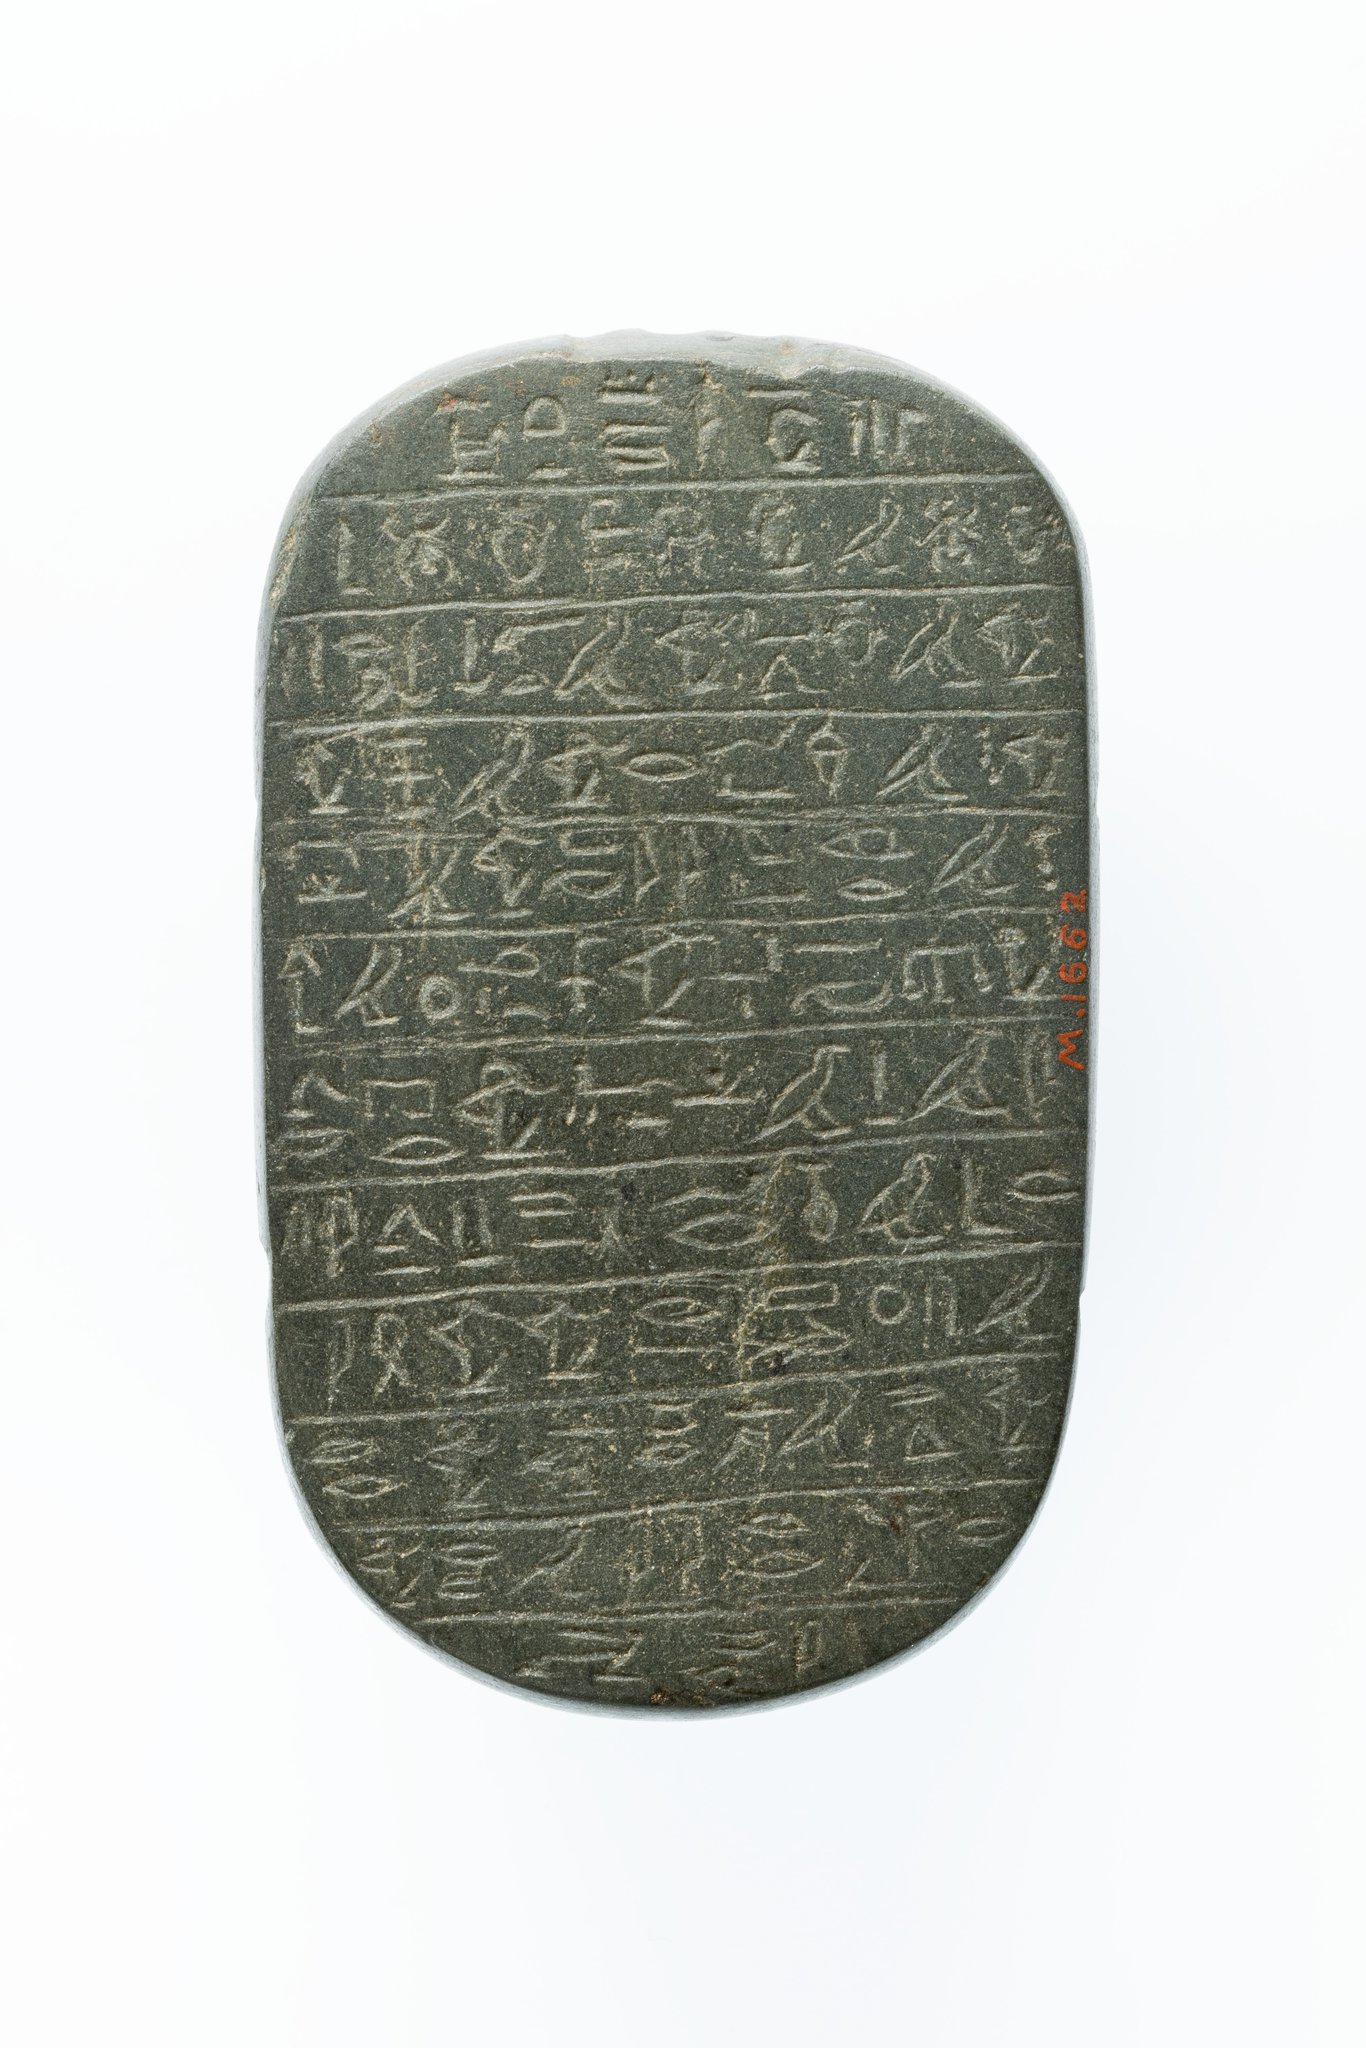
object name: heart scarab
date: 1070-664 BCE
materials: quartzite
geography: egypt